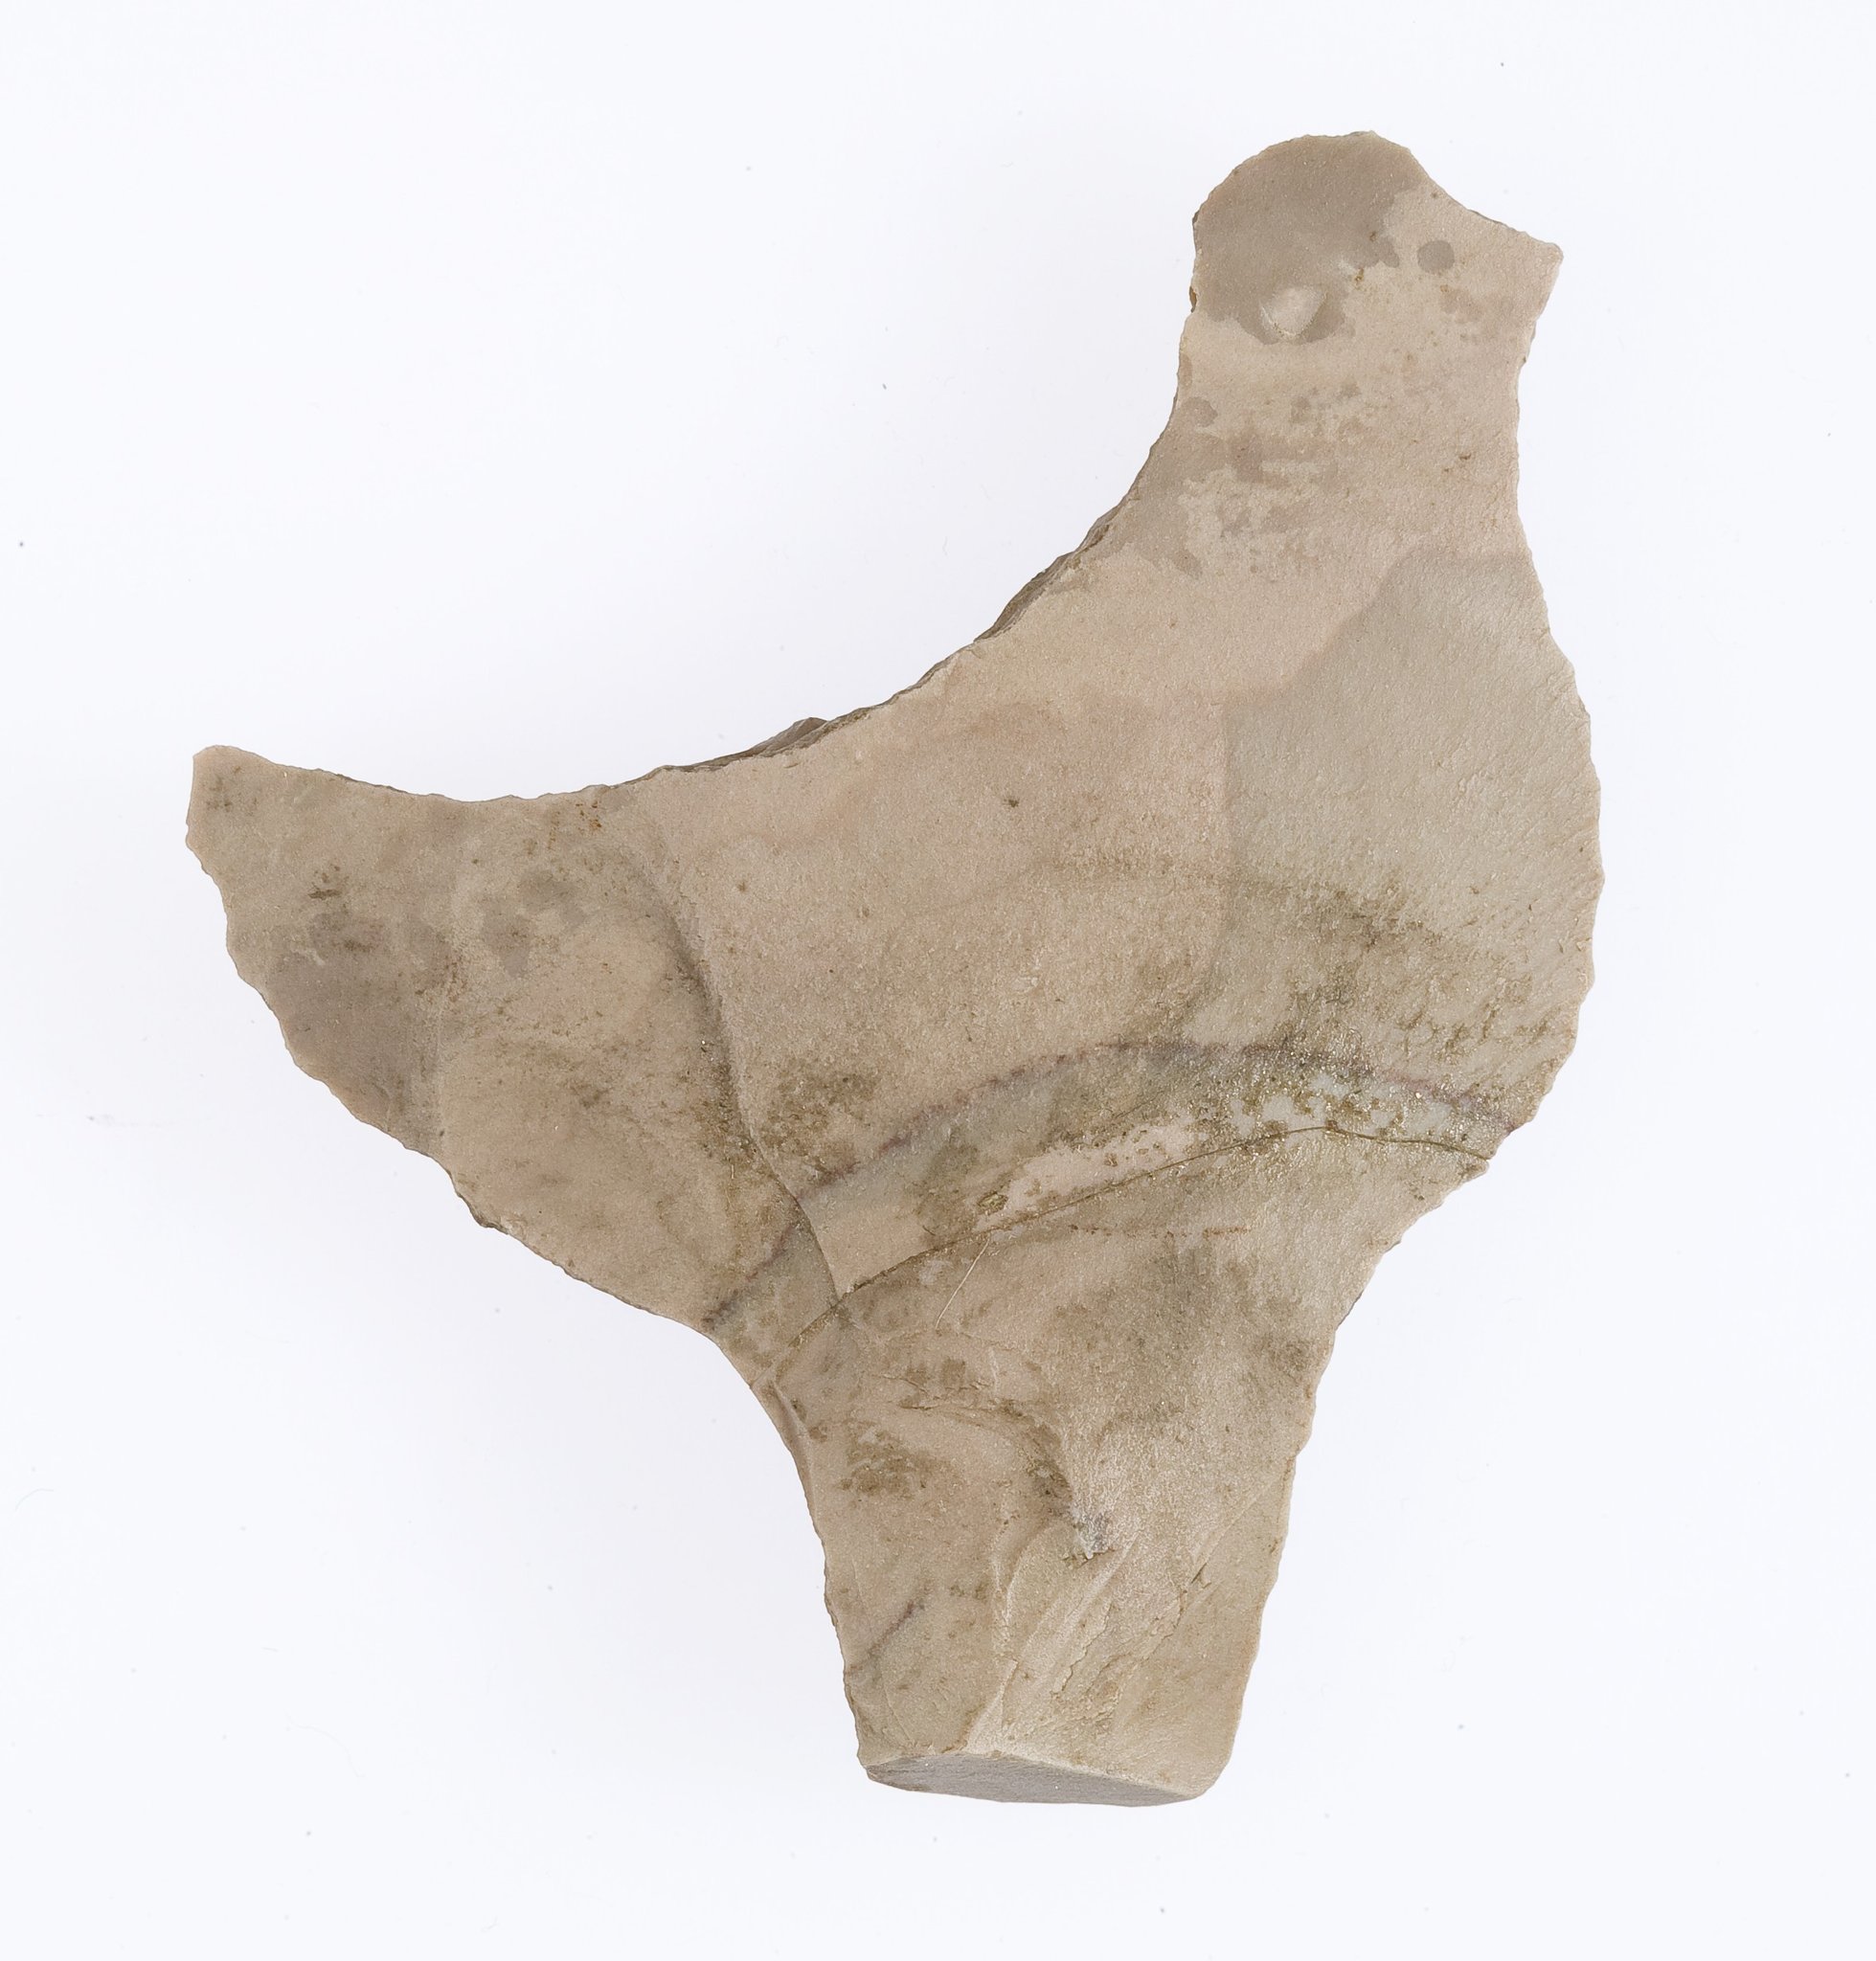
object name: eccentric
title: Flint shaped like a bird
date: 3300-2900 BCE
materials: stone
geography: egypt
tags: birds